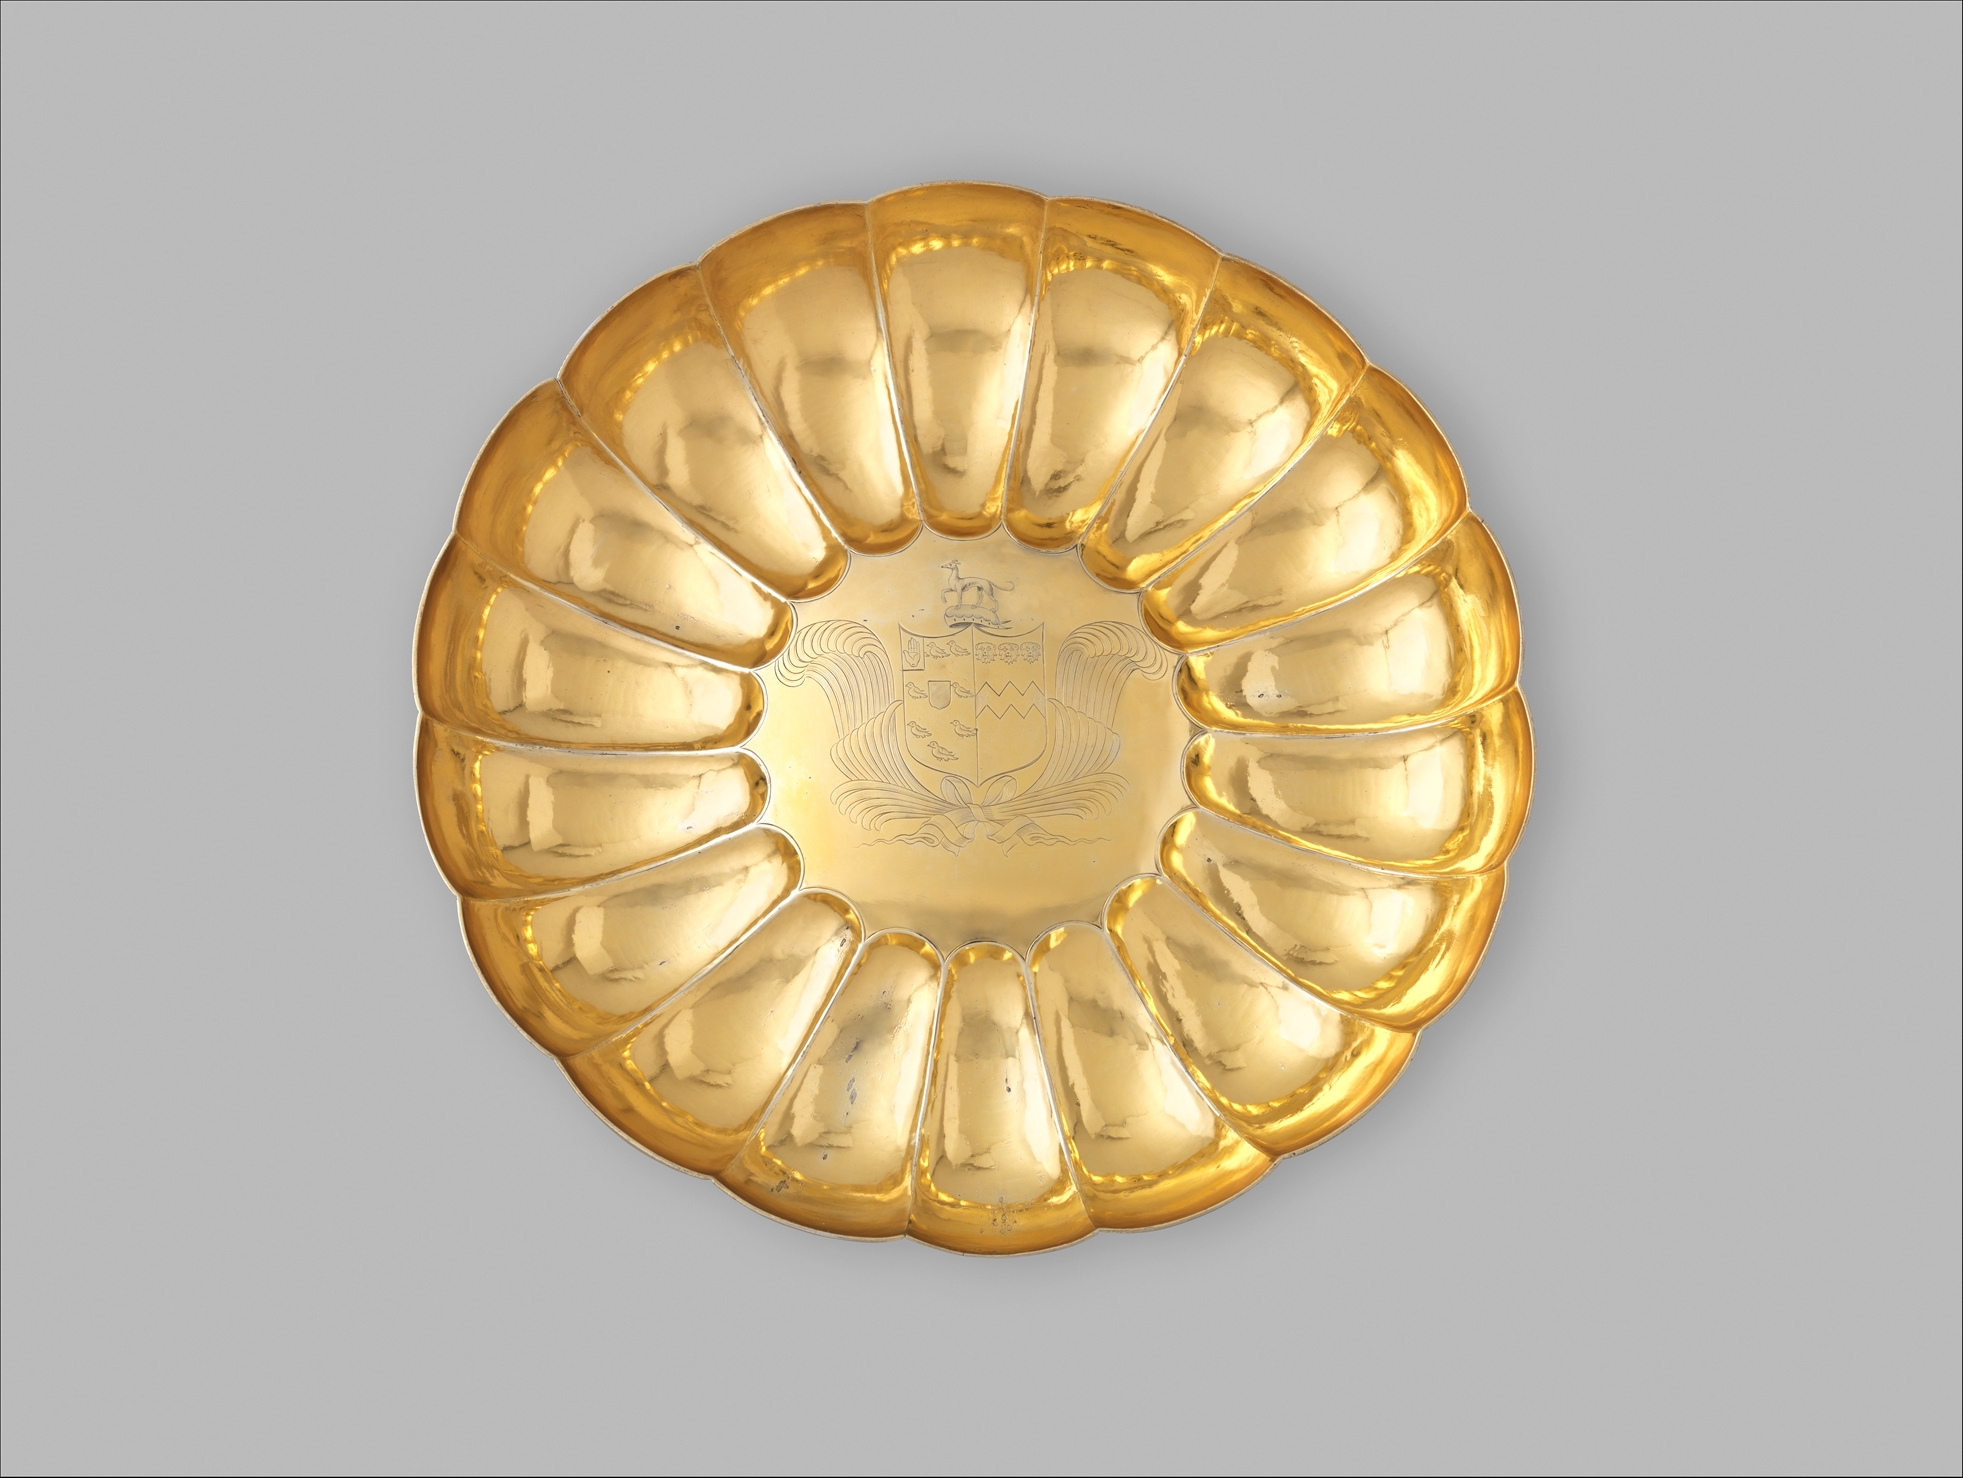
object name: dish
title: Dish (one of a pair)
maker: anthony ficketts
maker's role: maker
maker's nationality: british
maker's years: 1635-1685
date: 1664-1665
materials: silver gilt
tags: coat of arms